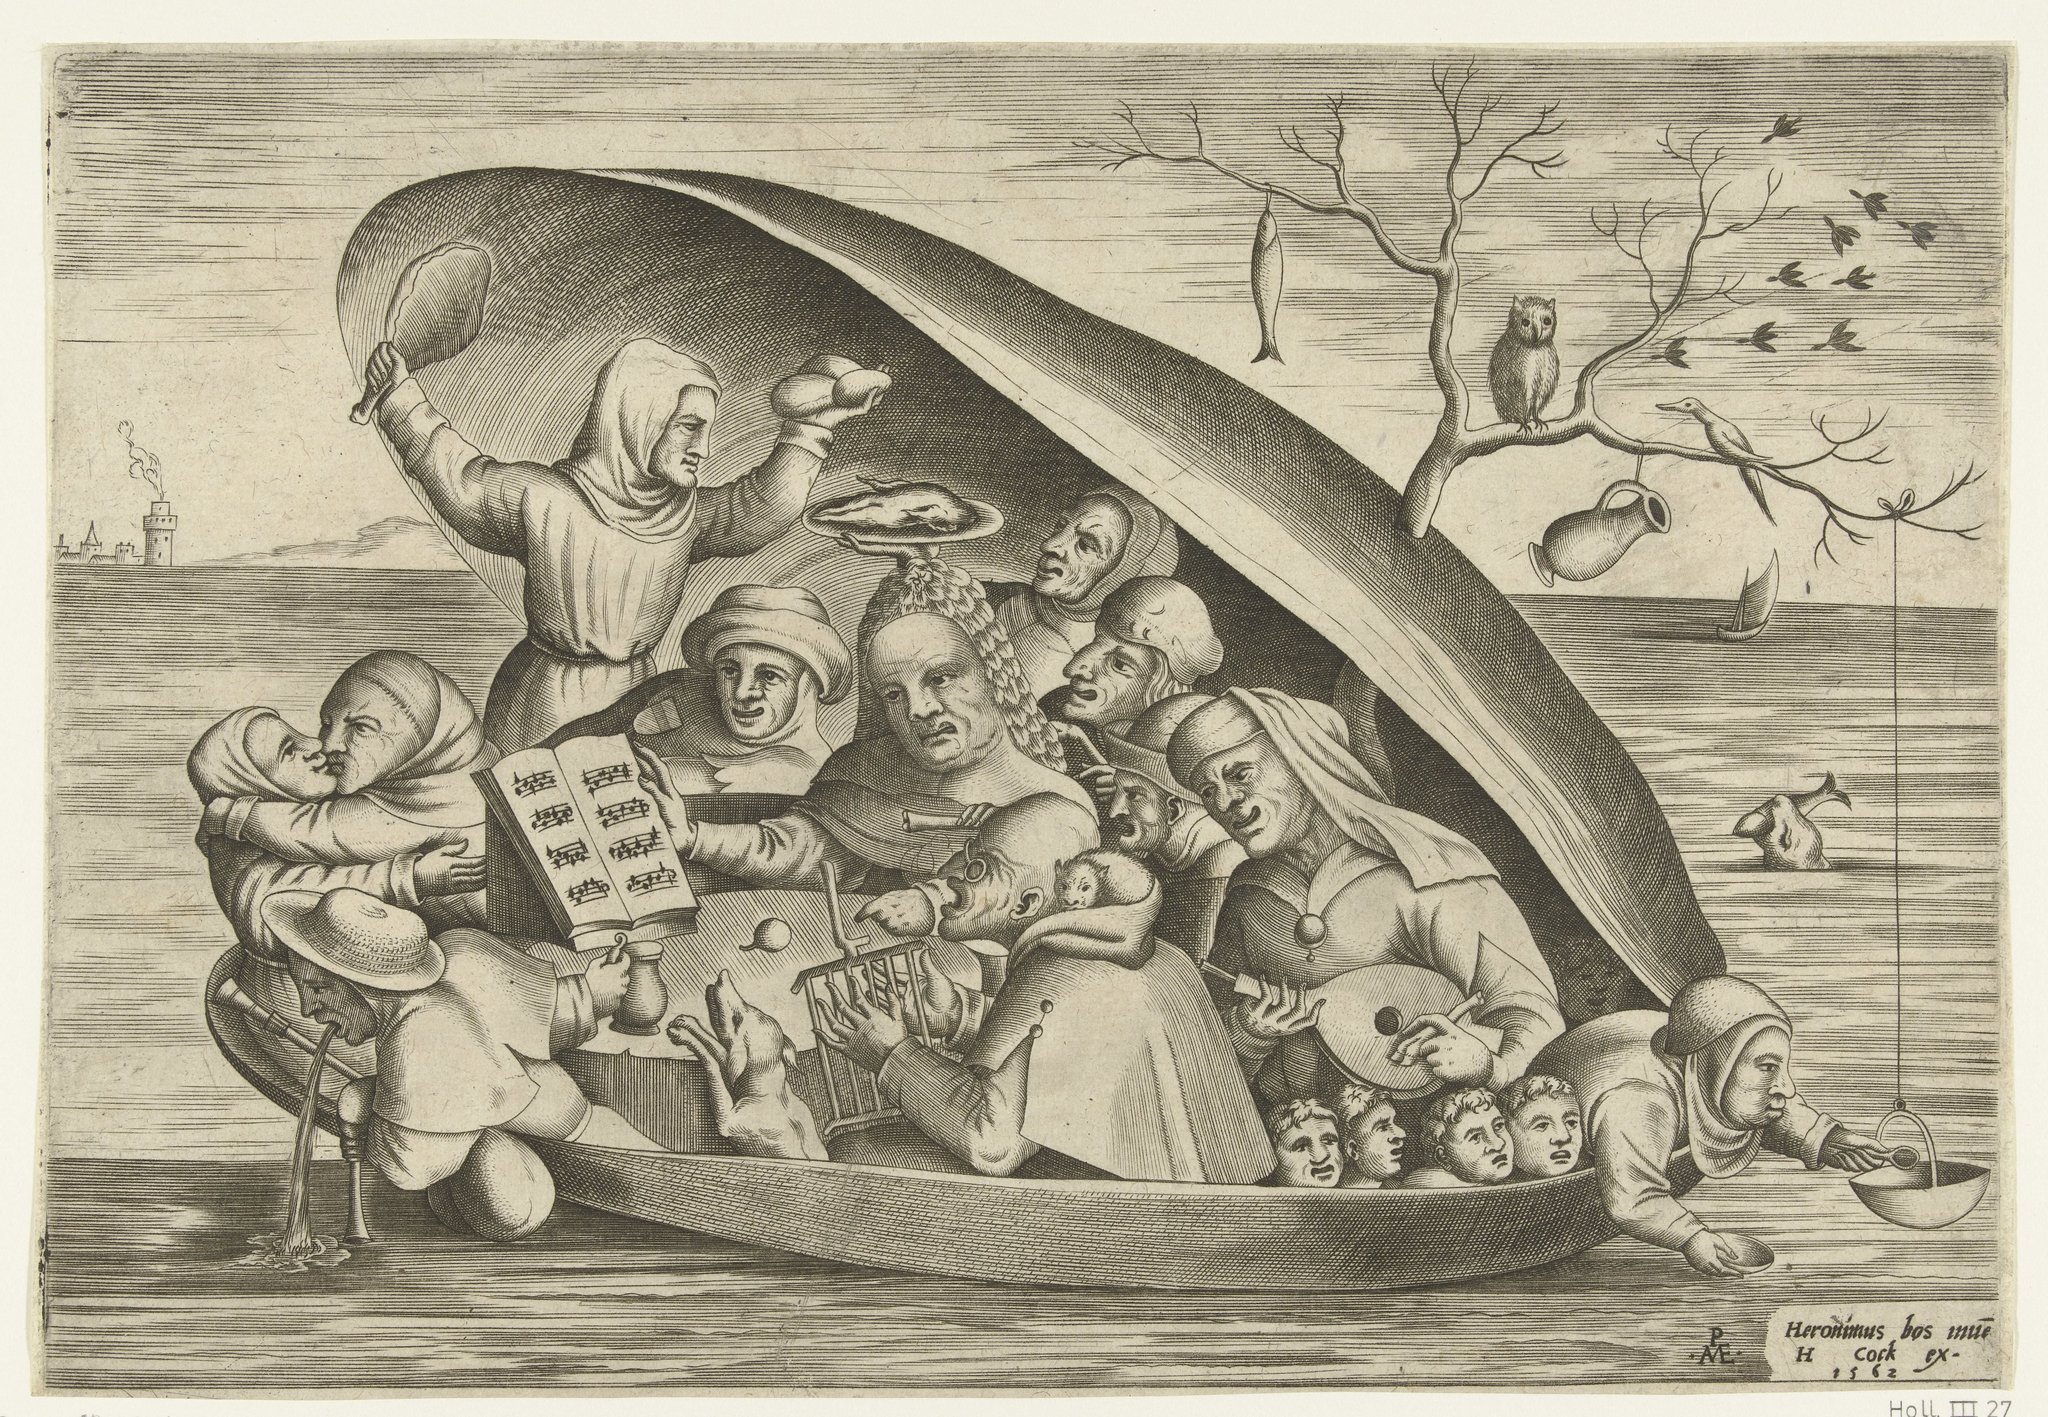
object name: print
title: Muzikanten in een mosselschelp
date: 1562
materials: paper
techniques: engraving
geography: antwerp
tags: (aspects of) christian religion or the church (as institution) ridiculed, criticized, or caricaturized, improvised musical instruments (kitchen-utensils, etc.), owls (+ animals used symbolically), ship of fools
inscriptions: date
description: Een gezelschap van muzikanten, zangers en geestelijken in een varende mosselschelp maken rond een tafel muziek, zingen, eten, drinken en vrijen. Links braakt een doedelzakspeler in het water en omhelst een monnik een vrouw. Uit de schelp steekt een boomtak waarop een uil zit. Een man maakt muziek op een haardijzer.